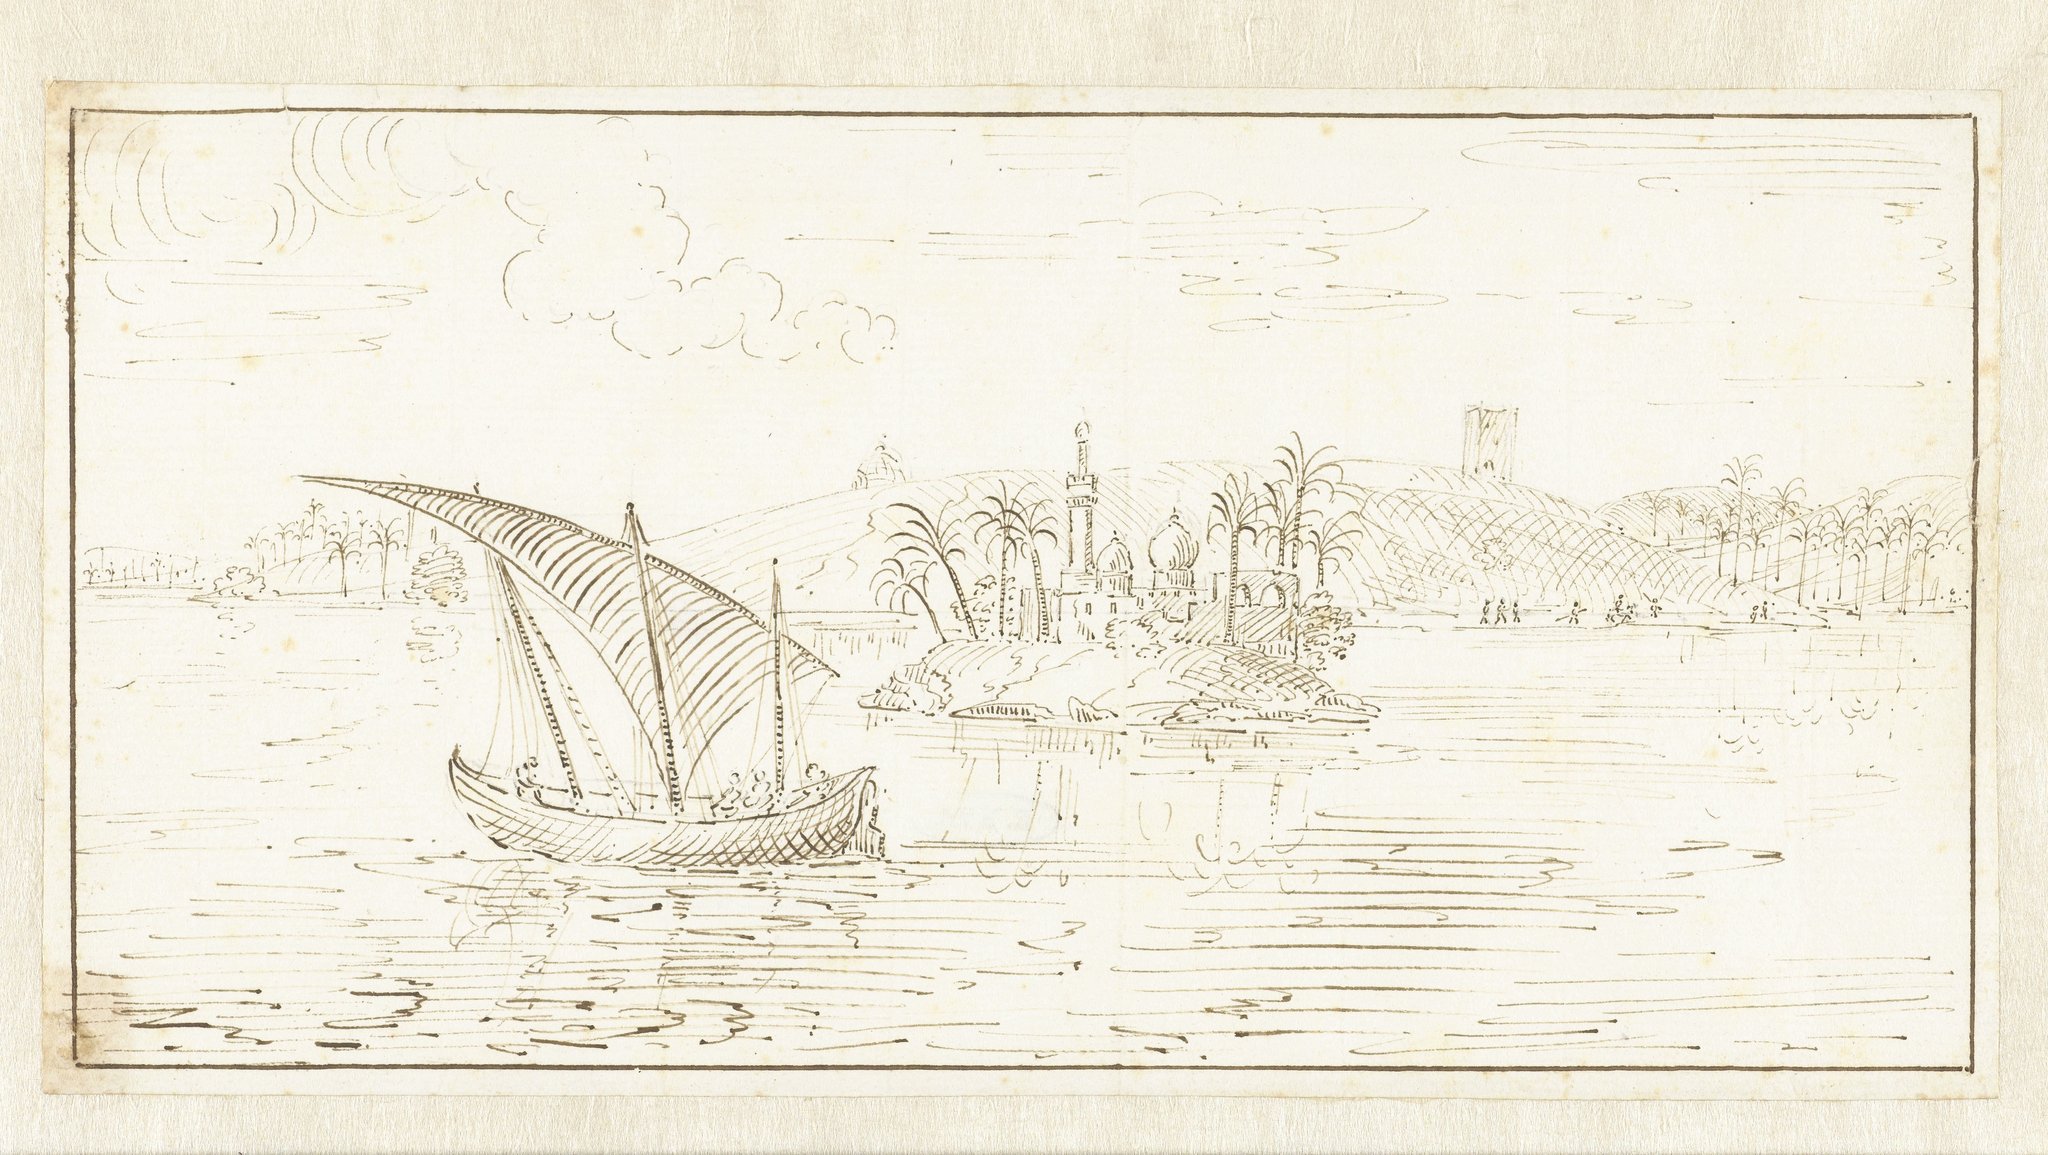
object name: drawing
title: Gezichten rond de Middellandse Zee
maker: johan teyler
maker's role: draughtsman, print maker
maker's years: 1648-1712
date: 1679-1683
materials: ink, paper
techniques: pen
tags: landscapes with waters, waterscapes, seascapes (in the temperate zone)